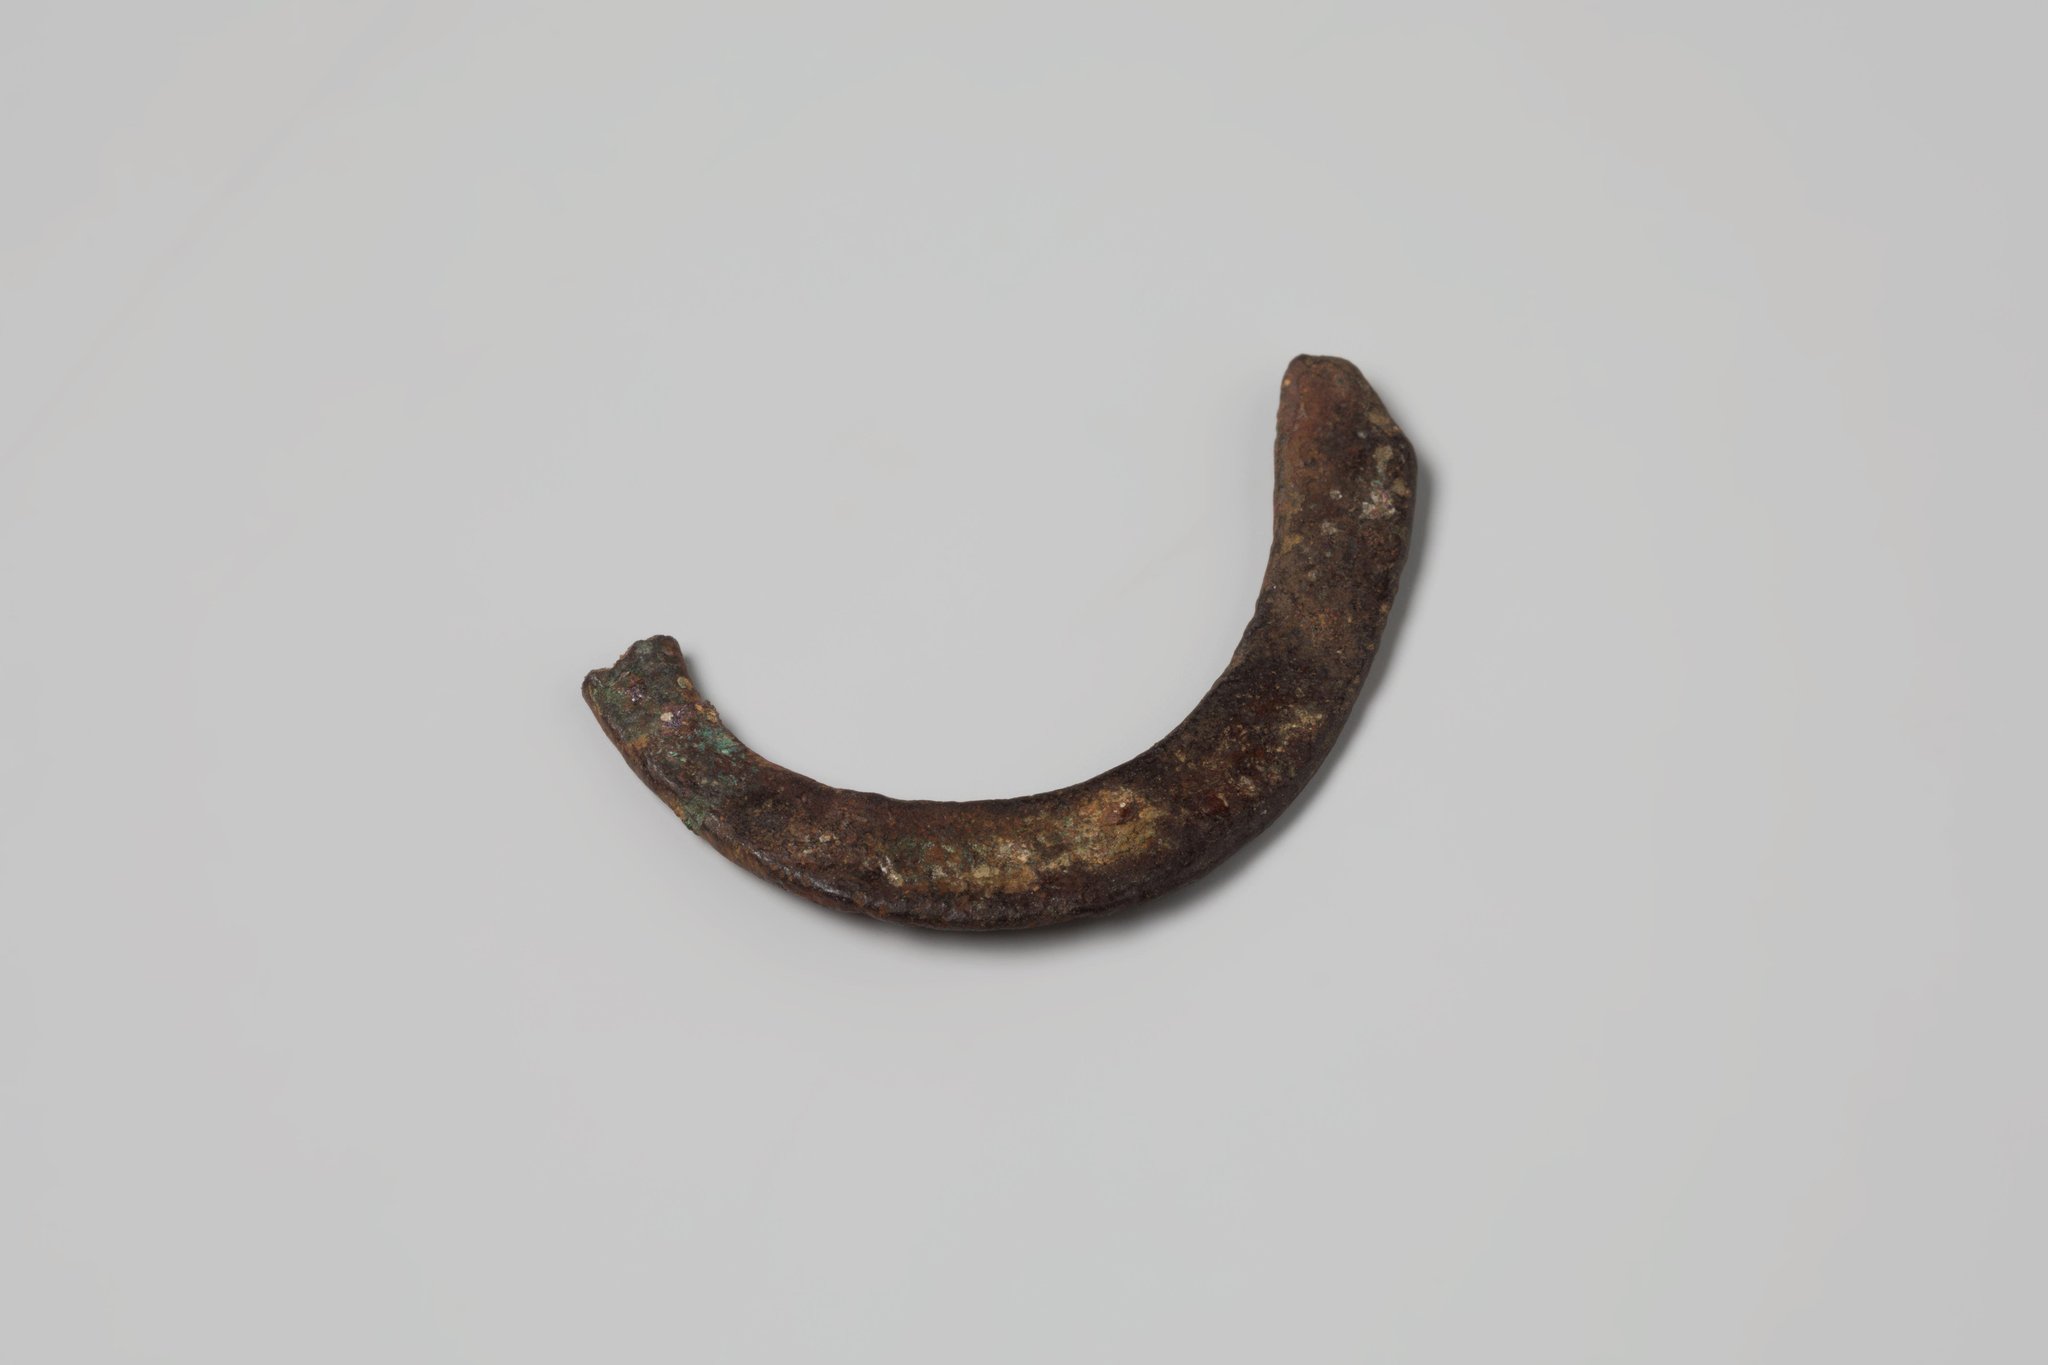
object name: divider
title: Fragment steekpasser uit het wrak van de Oost-Indiëvaarder Hollandia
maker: Anonymous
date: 1700-1743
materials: copper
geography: netherlands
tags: verenigde oostindische compagnie, hollandia (schip), annet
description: Divider; fragment, semicircular ring, id. NG 1980-27H1171, eroded.